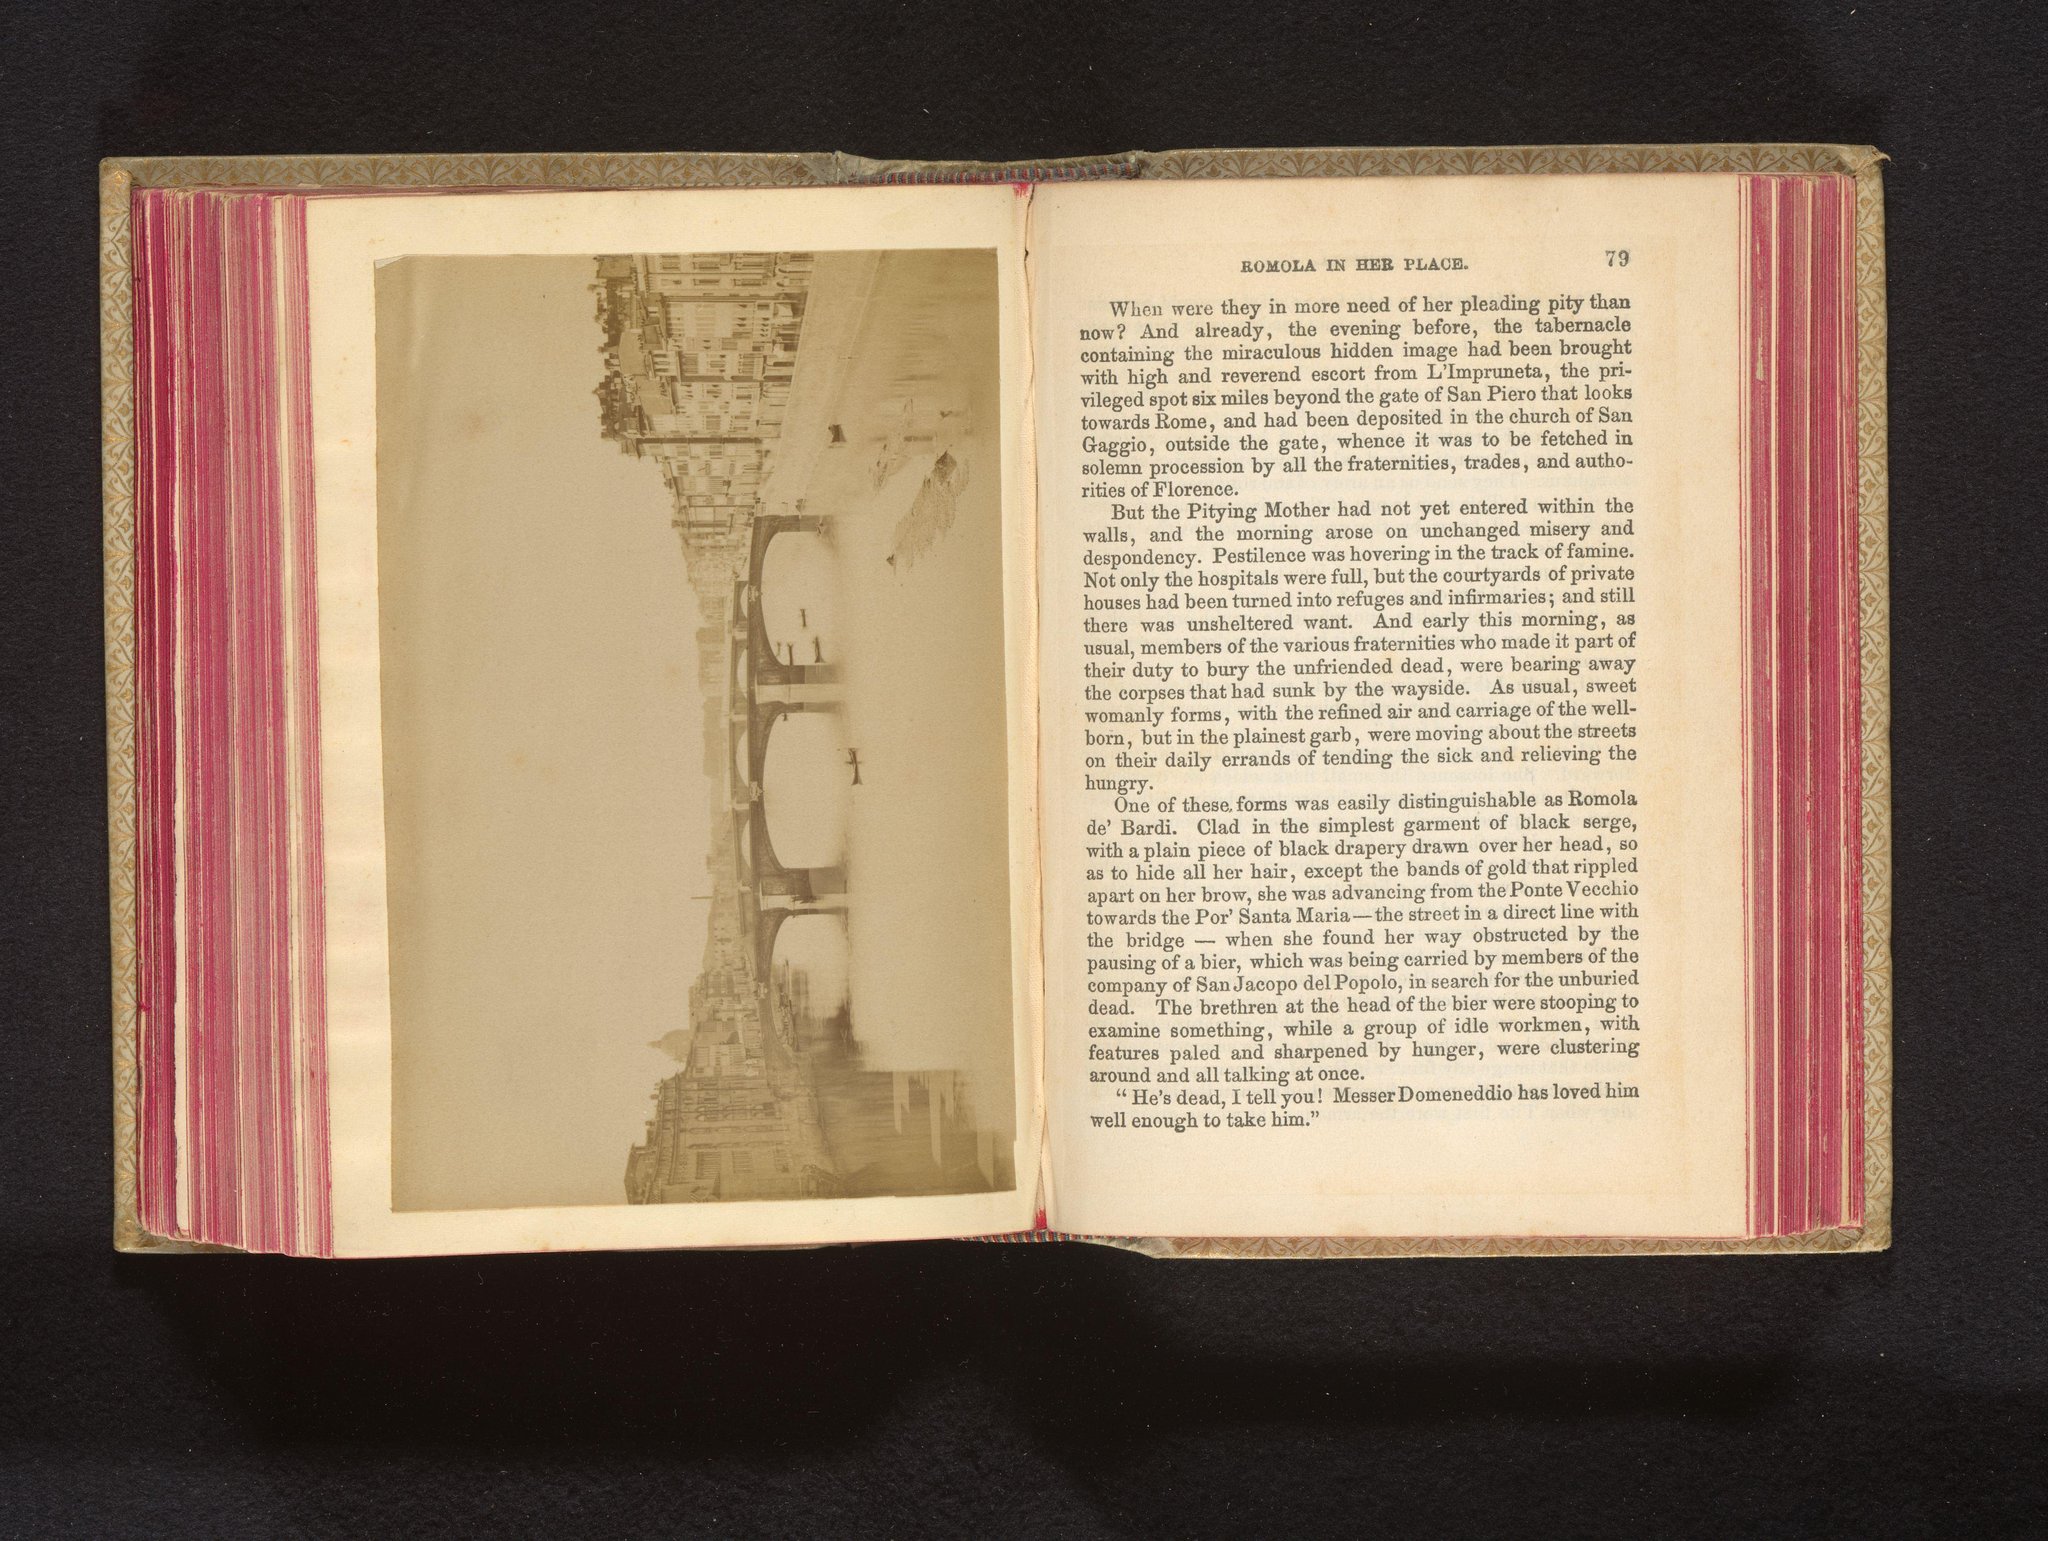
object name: photograph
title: Gezicht op de Arno te Florence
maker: Anonymous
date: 1858-1863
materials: photographic support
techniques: albumen print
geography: arno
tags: river, bridge